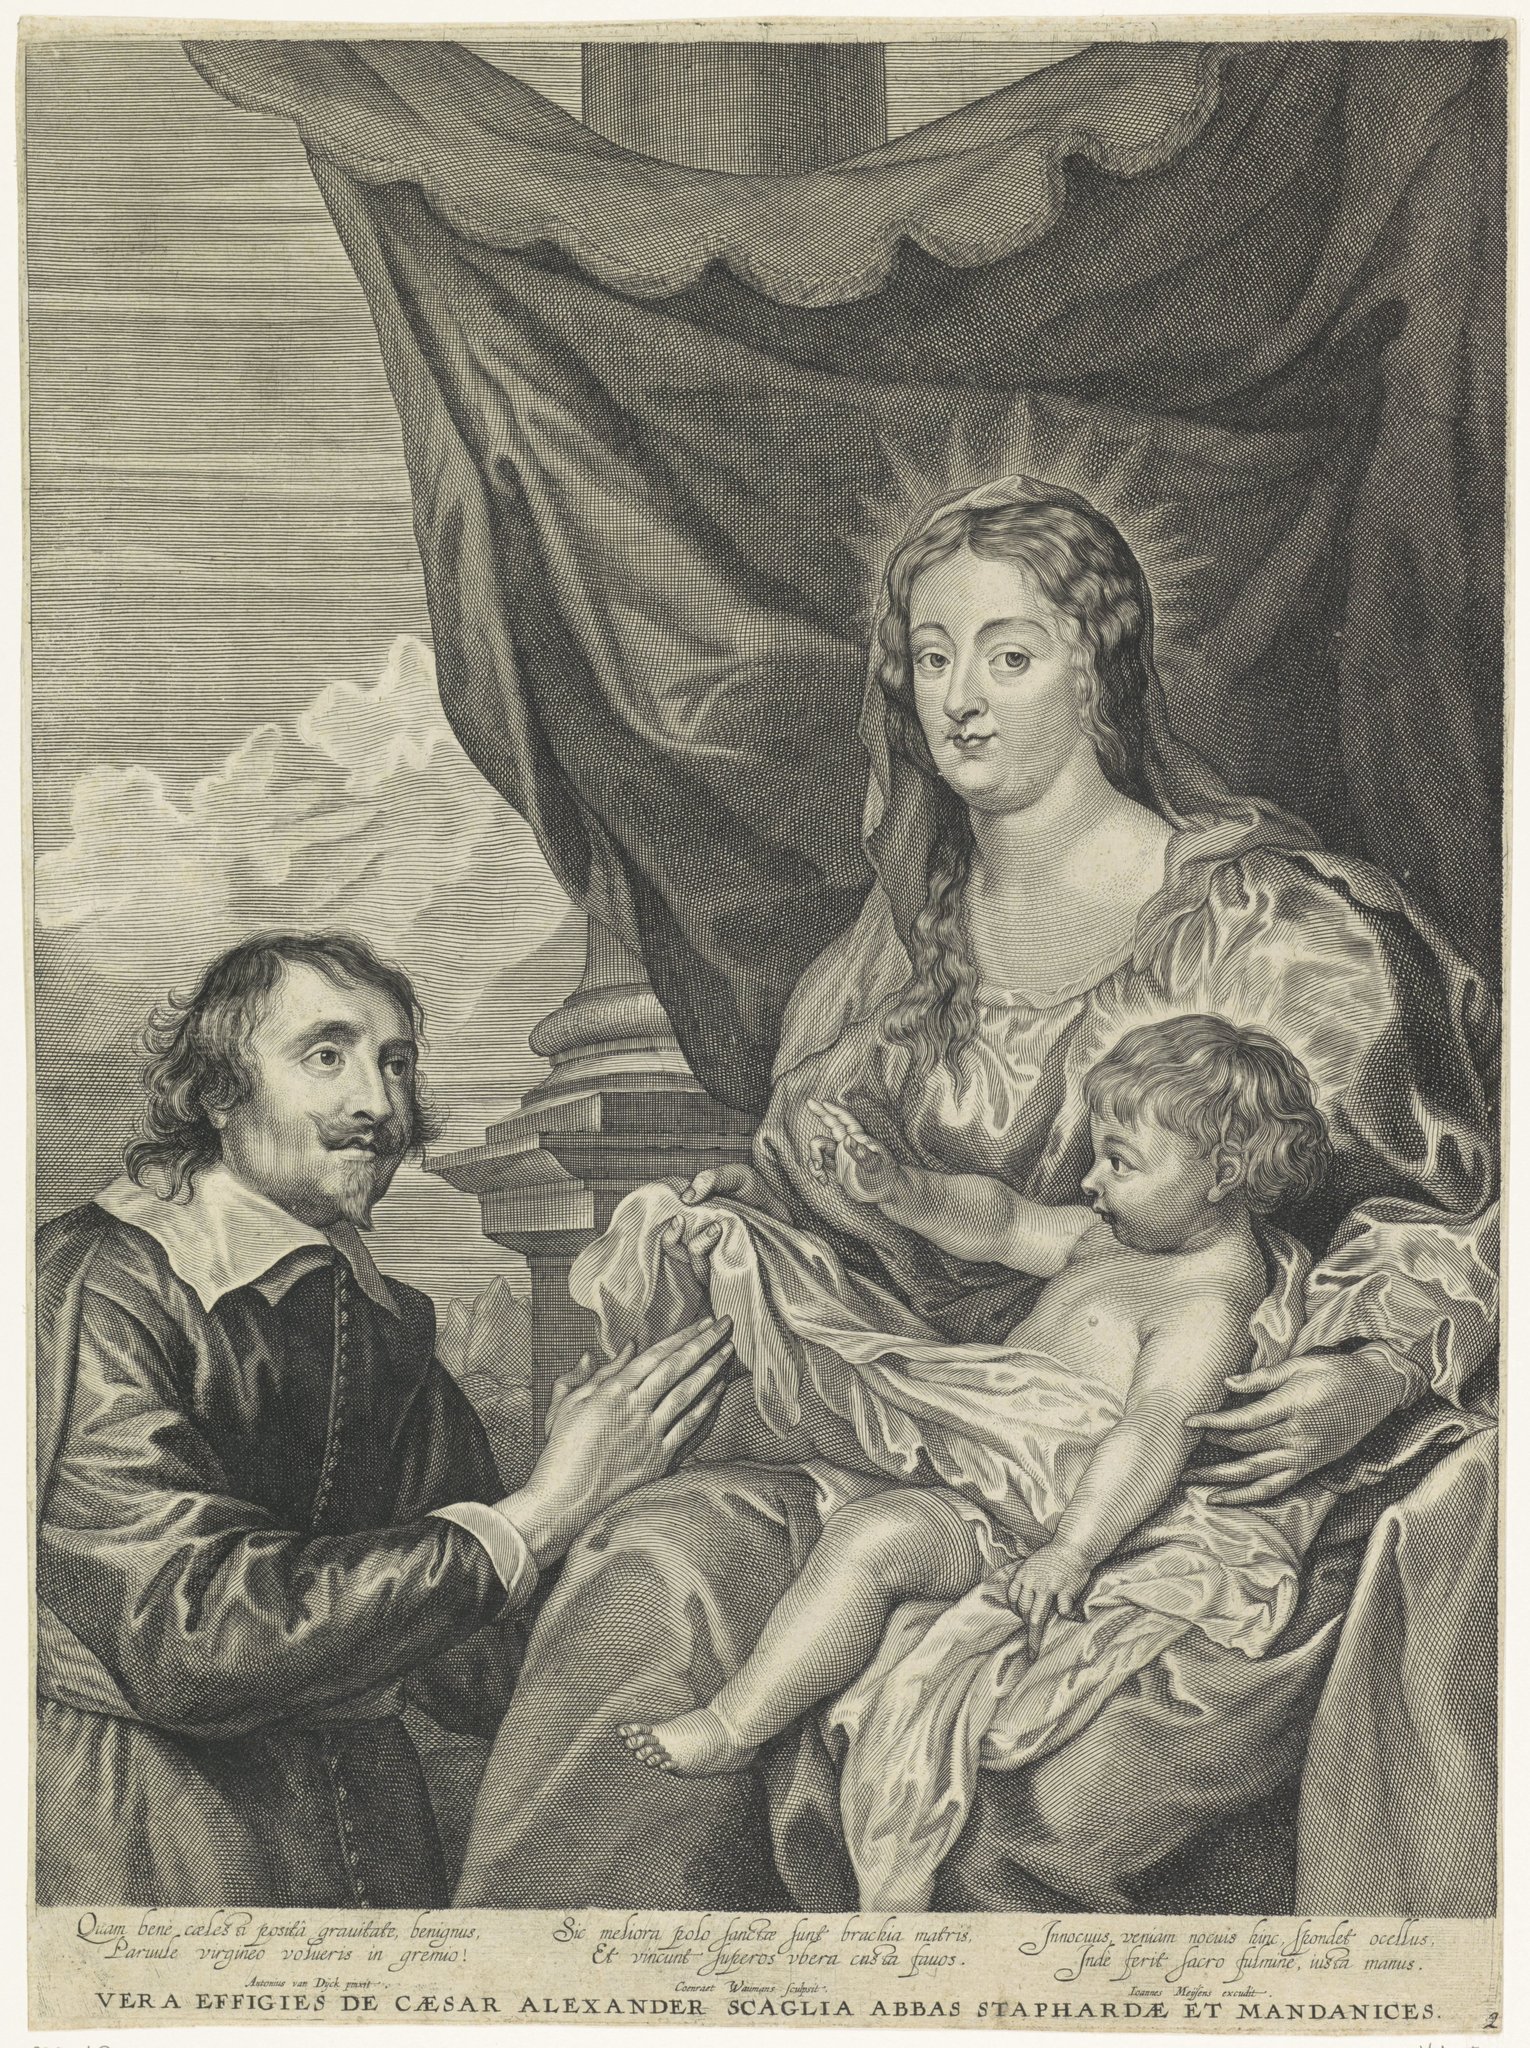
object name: print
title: Maria en het Christuskind aanbeden door Cesare Alessandro Scaglia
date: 1633-1673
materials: paper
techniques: engraving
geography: antwerp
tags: madonna: mary sitting or enthroned, the christ-child in her lap (or in front of her bosom) (mary sometimes represented half-length), mary together with mortals, who adore her, or implore her to help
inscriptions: collector's mark: Lugt 10, number: ‘2’, collector's mark: Lugt 11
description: Cesare Alessandro Scaglia knielt in aanbidding voor Maria en het Christuskind. Het Kind zegent hem. In de marge een zesregelig onderschrift, in drie kolommen, in het Latijn. Daaronder een regel met de naam van de geportretteerde in het Latijn.